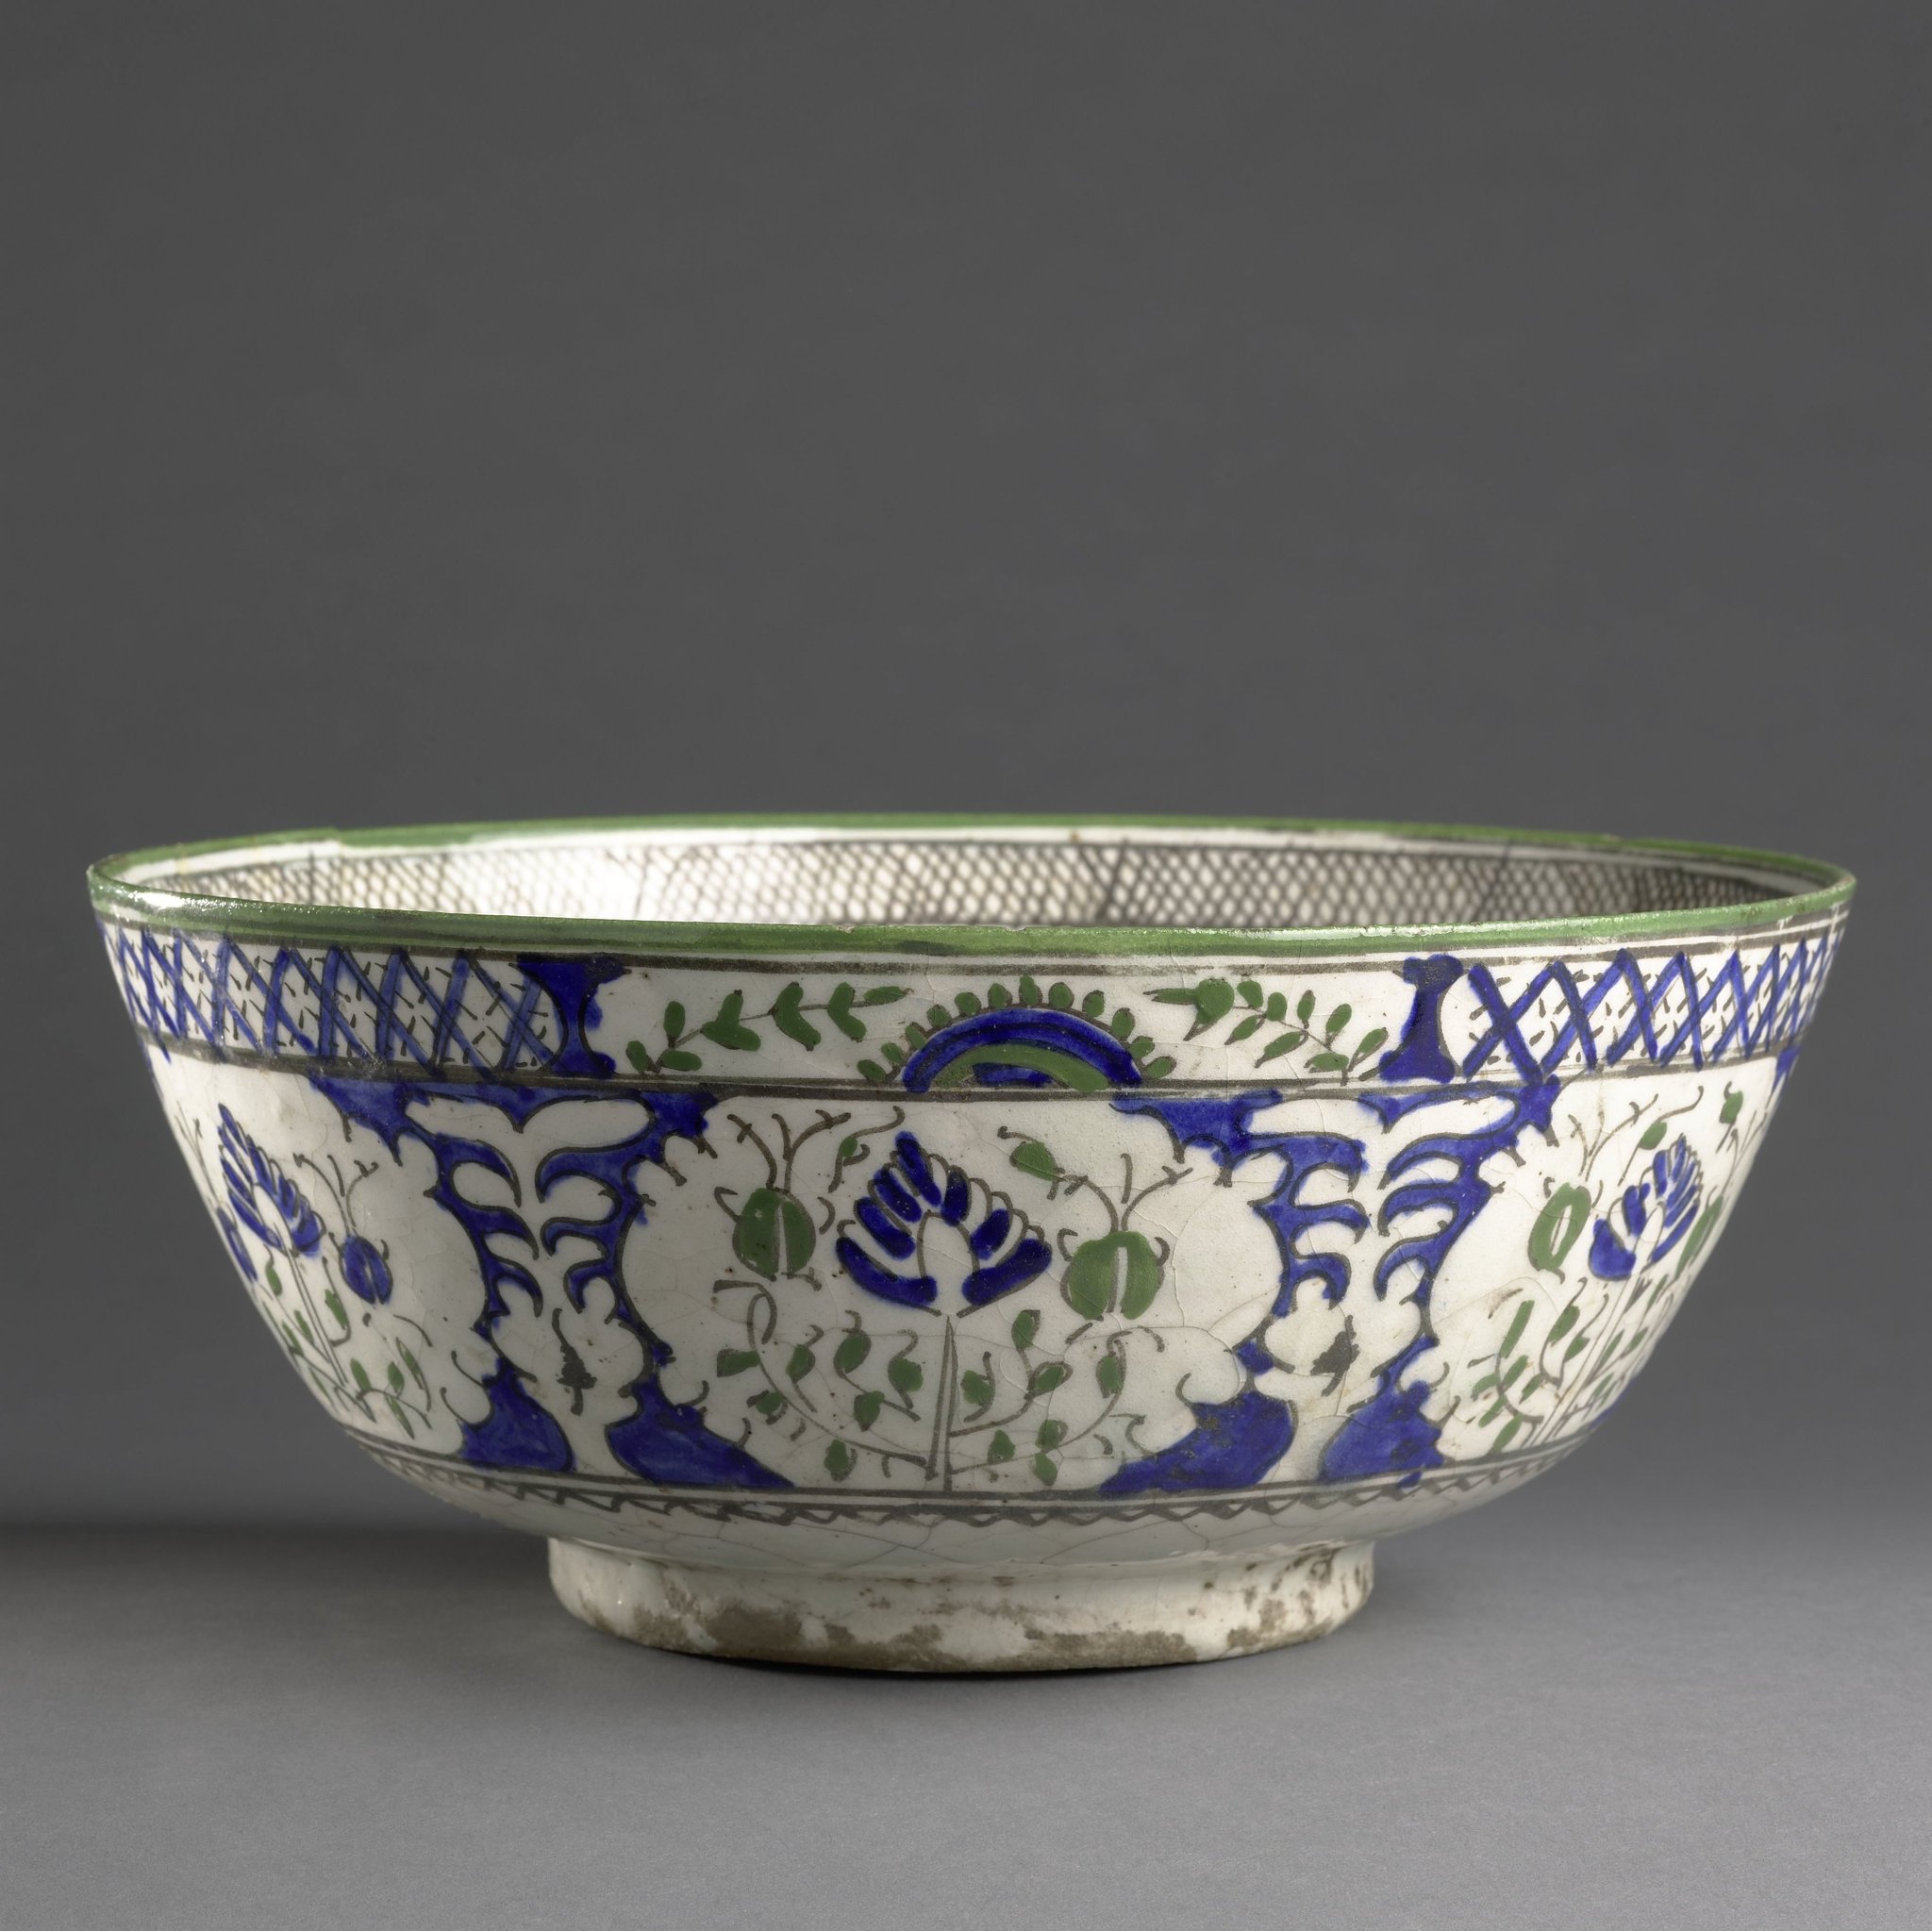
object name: bowl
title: Bowl with a peacock, flowering plant and inscription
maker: Anonymous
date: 1800-1999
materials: earthenware, glaze, paint, quartz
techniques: firing, turning, vitrification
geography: iran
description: Kom van kwarts-fritgoed, met veelkleurige beschildering. Op de binnenzijde een pauw bij een gestileerde bloeiende plant met daaromheen een opschrift. De binnenrand met een decoratieve band. De buitenzijde met een band met gelobde cartouches met een bloemtak, gescheiden door een bloem uitgespaard in blauw. Op de buitenrand een band met een geometrisch motief onderbroken door een cartouche met een bloemtak.